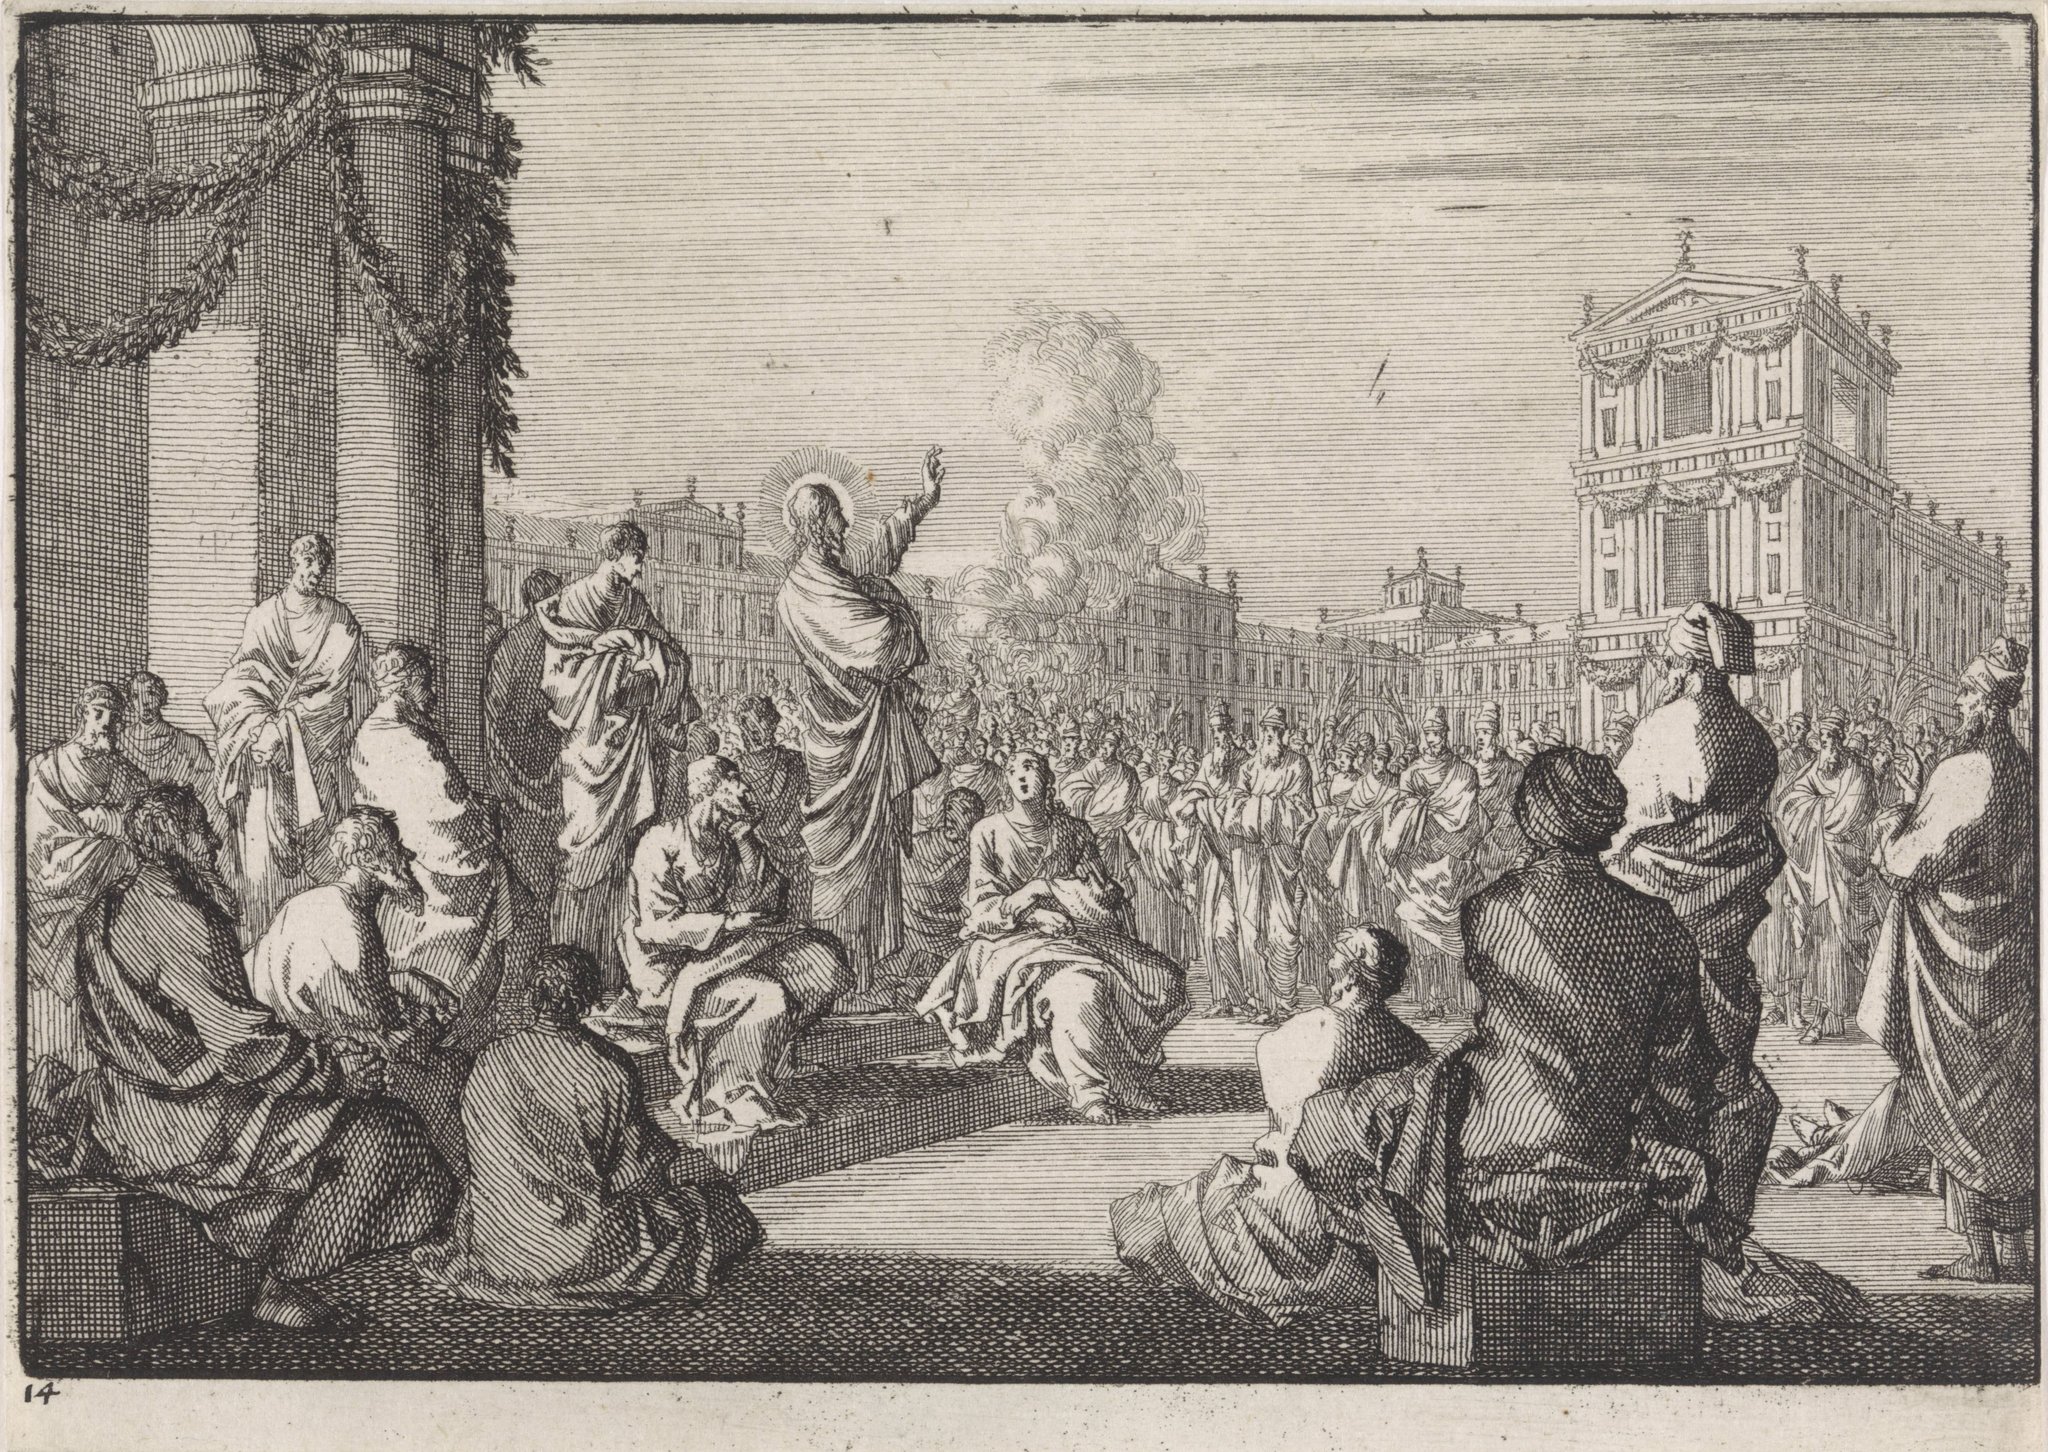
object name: print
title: Preek van Christus voor de tempel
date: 1703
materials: paper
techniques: etching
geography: amsterdam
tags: christ is teaching in the temple in the middle of the feast of tabernacles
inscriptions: collector's mark: Lugt 2228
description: Proefdruk van een boekillustratie voor David Martin. Historie des Ouden en Nieuwen Testaments. Amsterdam, Pieter Mortier, 1703. Deel II. De boekillustraties voor de Mortierbijbel hebben verschillende staten en kopieën, waarbij de chronologische volgorde moeilijk te achterhalen valt. Als boekillustraties werden ze bovendien herhaaldelijk opnieuw gebruikt voor andere boekwerken.